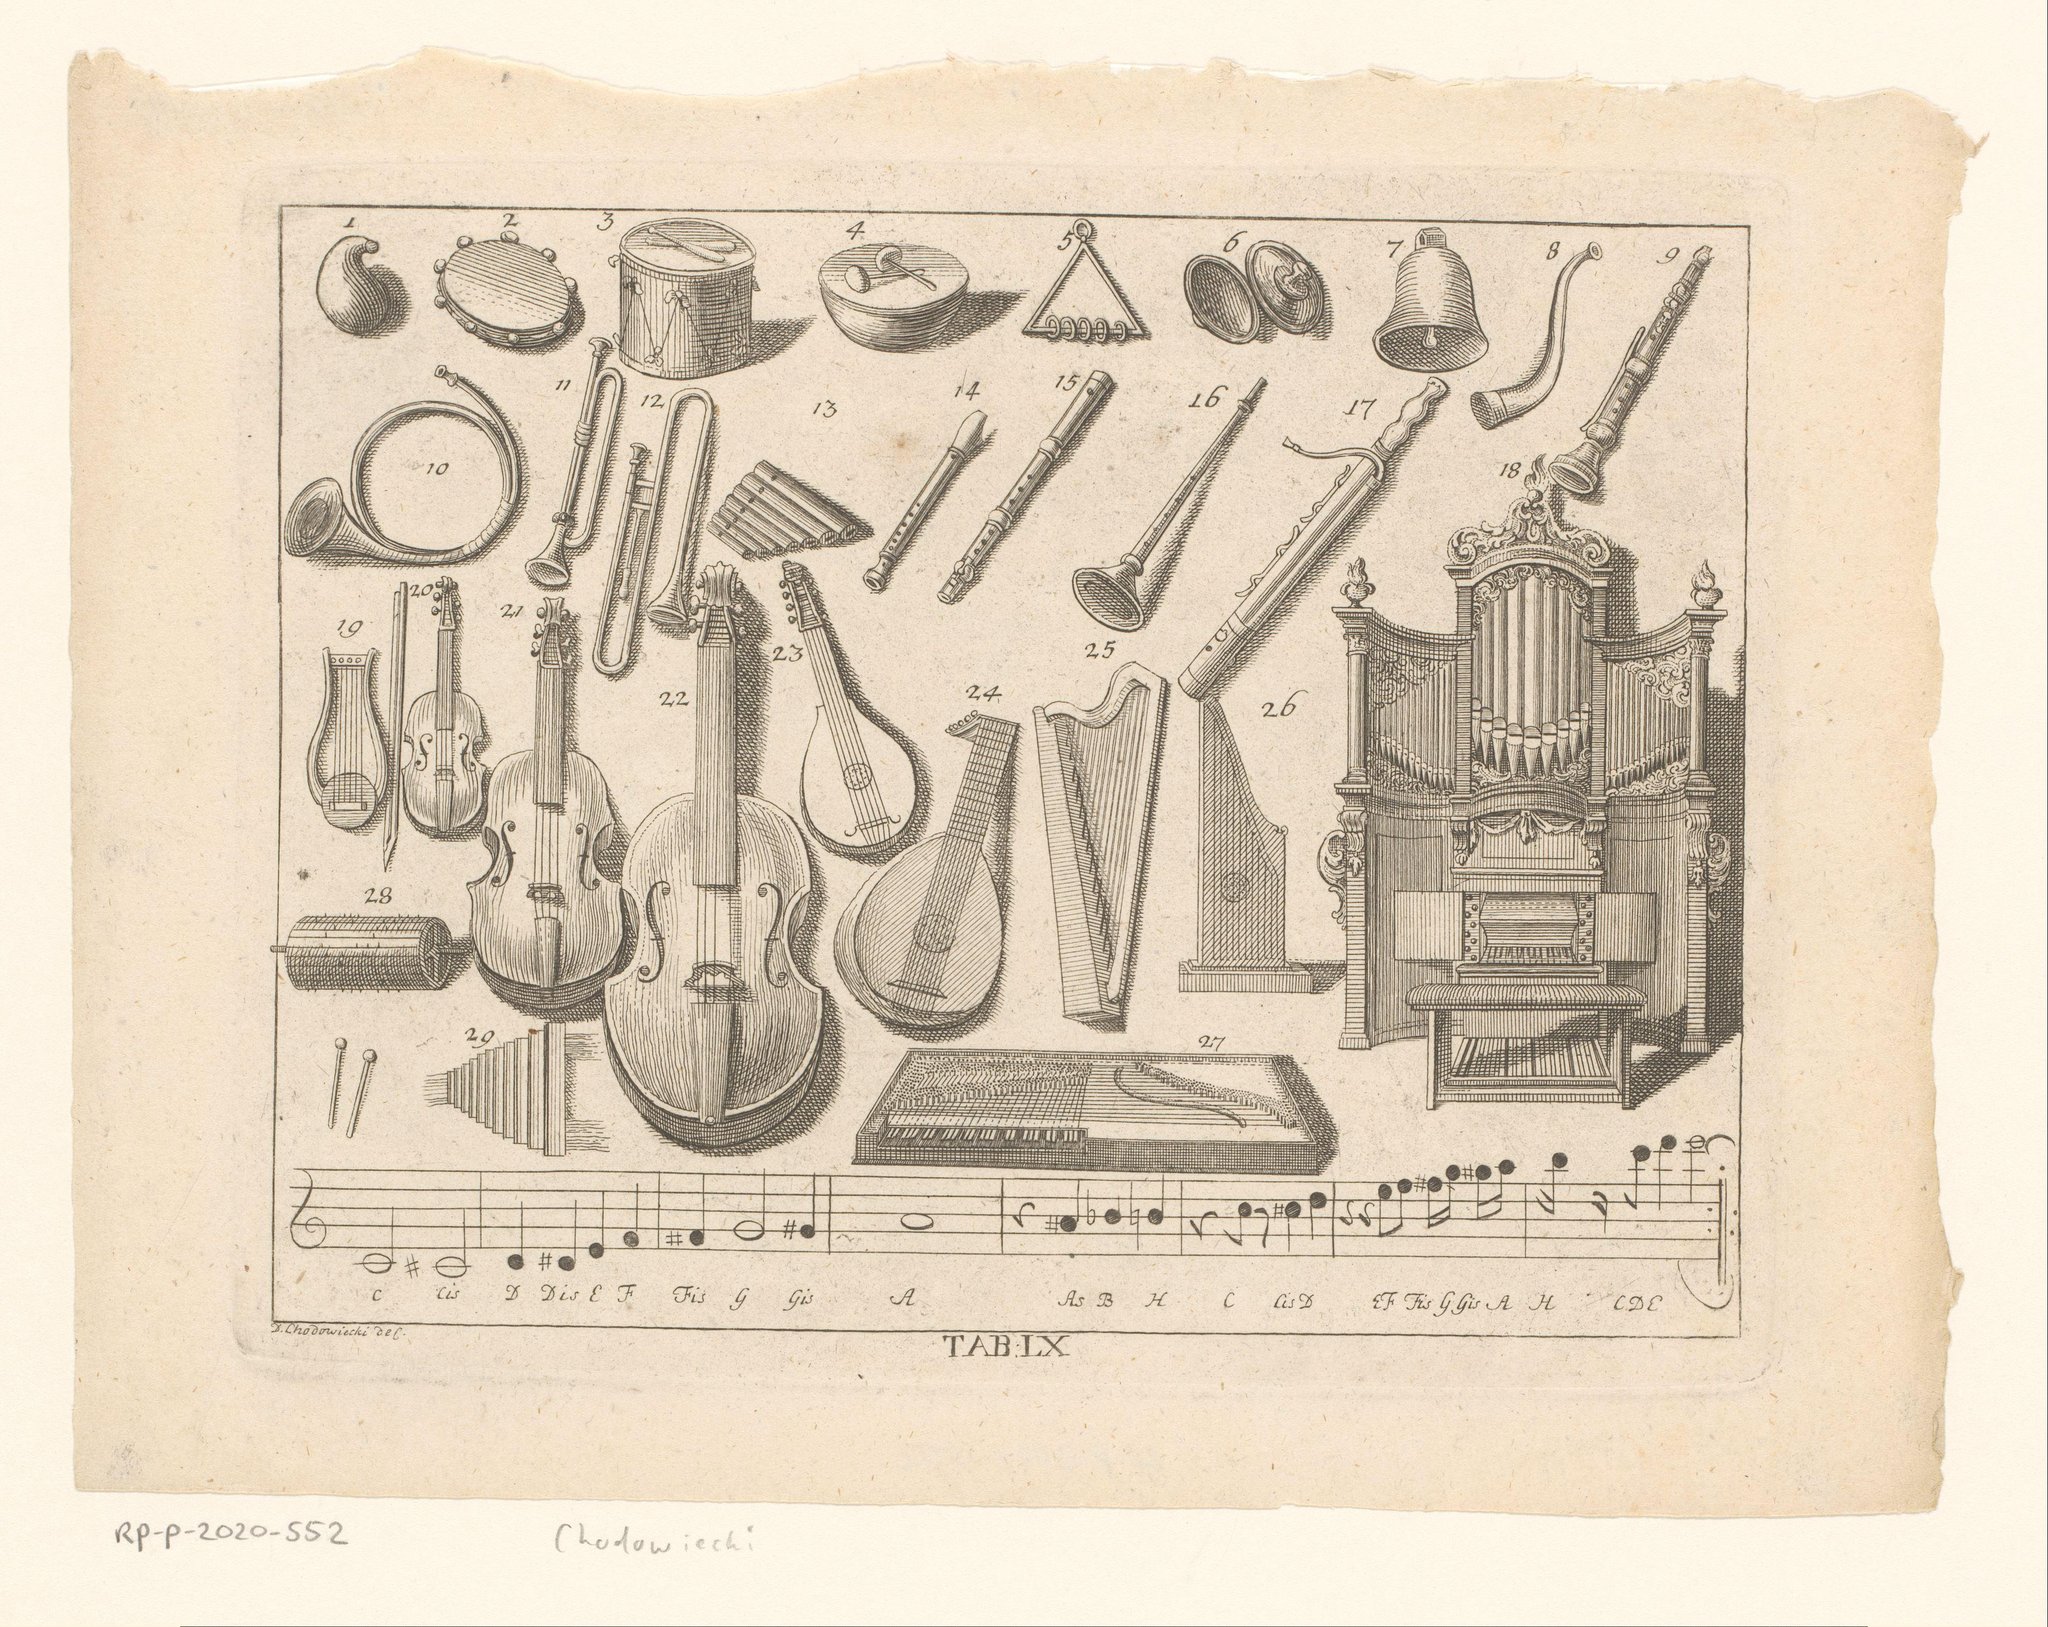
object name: print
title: Kupfersammlung zu J.B. Basedows Elementarwerk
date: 1774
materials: paper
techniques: etching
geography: leipzig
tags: notation of music, lyre, cithara, psaltery, panpipes, tambourine, violin, fiddle, harp, viola, violoncello; double bass, church organ, clarinet, bassoon, oboe, shawm, clavichord, harpsichord, other percussion instruments (with name), flute, aulos, tibia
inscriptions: collector's mark: Lugt 2228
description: De prent maakt onderdeel uit van een serie van 96 prenten die verschenen ter illustratie van het 'Elementarwerk' van de Duitse pedagoog Johann Bernhard Basedow. De prenten werden door verschillende kunstenaars vervaardigd naar tekeningen van Daniel Chodowiecki. In 1774 verscheen het verzamelde prentwerk onder de titel: Basedow, Johann Bernhard. Kupfersammlung zu J.B. Basedows Elementarwerk für die Jugend und ihre Freunde. Leipzig: S.L. Crusius, 1774.